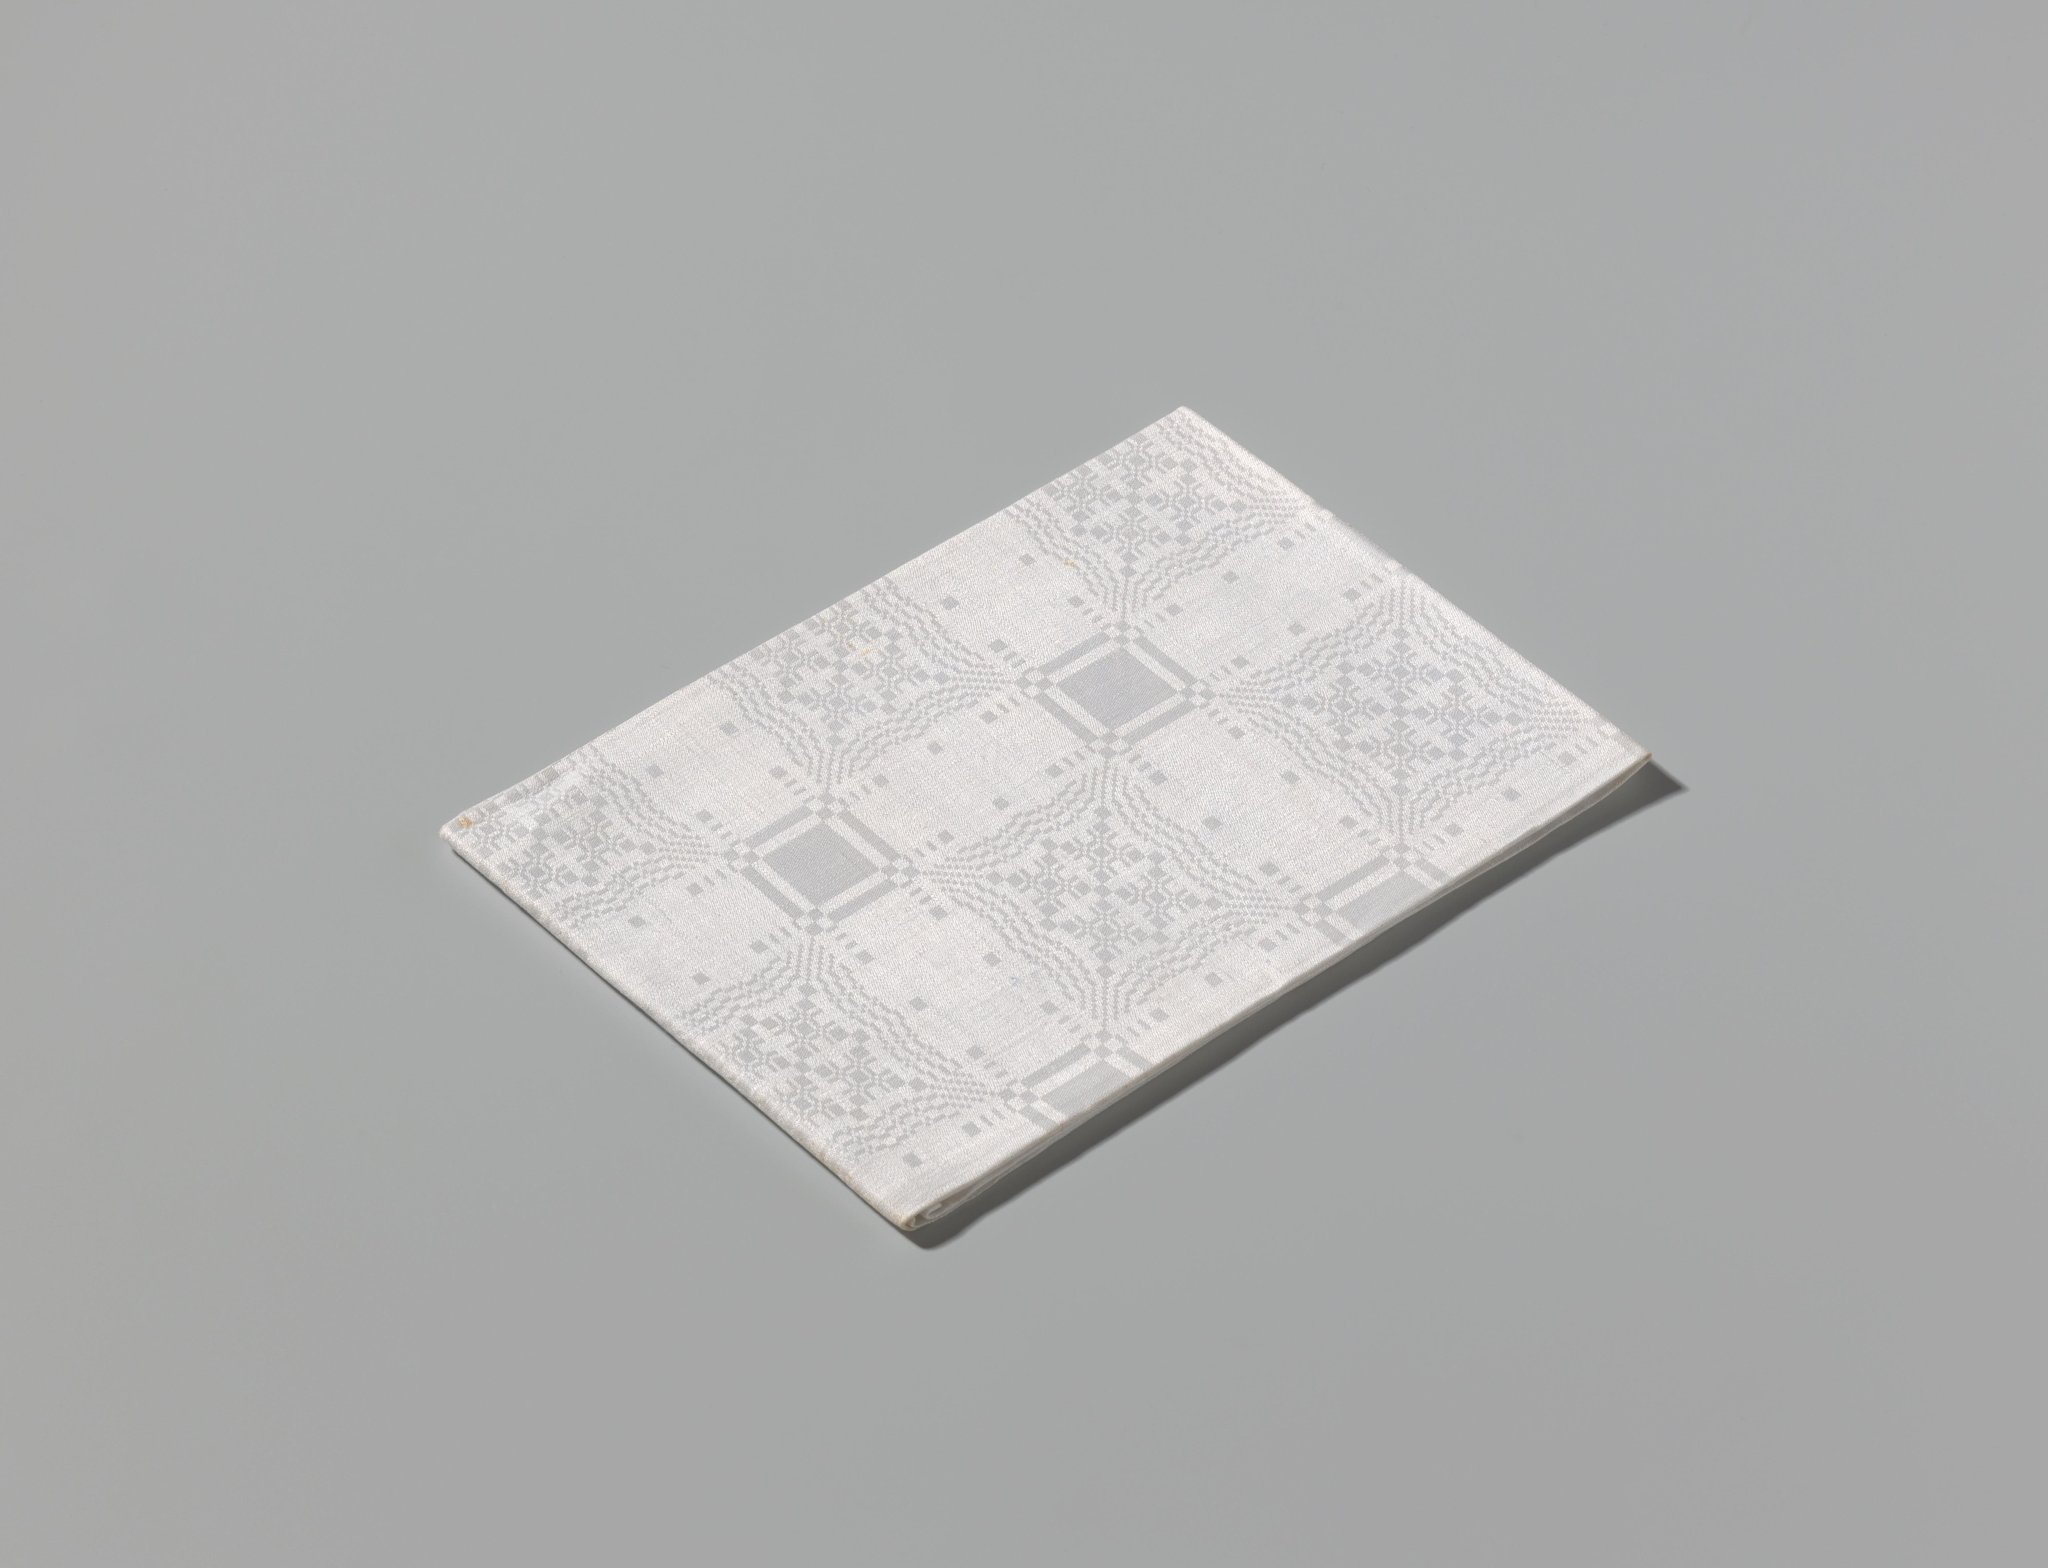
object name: napkin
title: Servet van linnen met pellenpatroon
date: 1734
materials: linen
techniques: peeled fabric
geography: northern netherlands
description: wit linnen servet met pellen patroon, merk AVG 38 en 1734